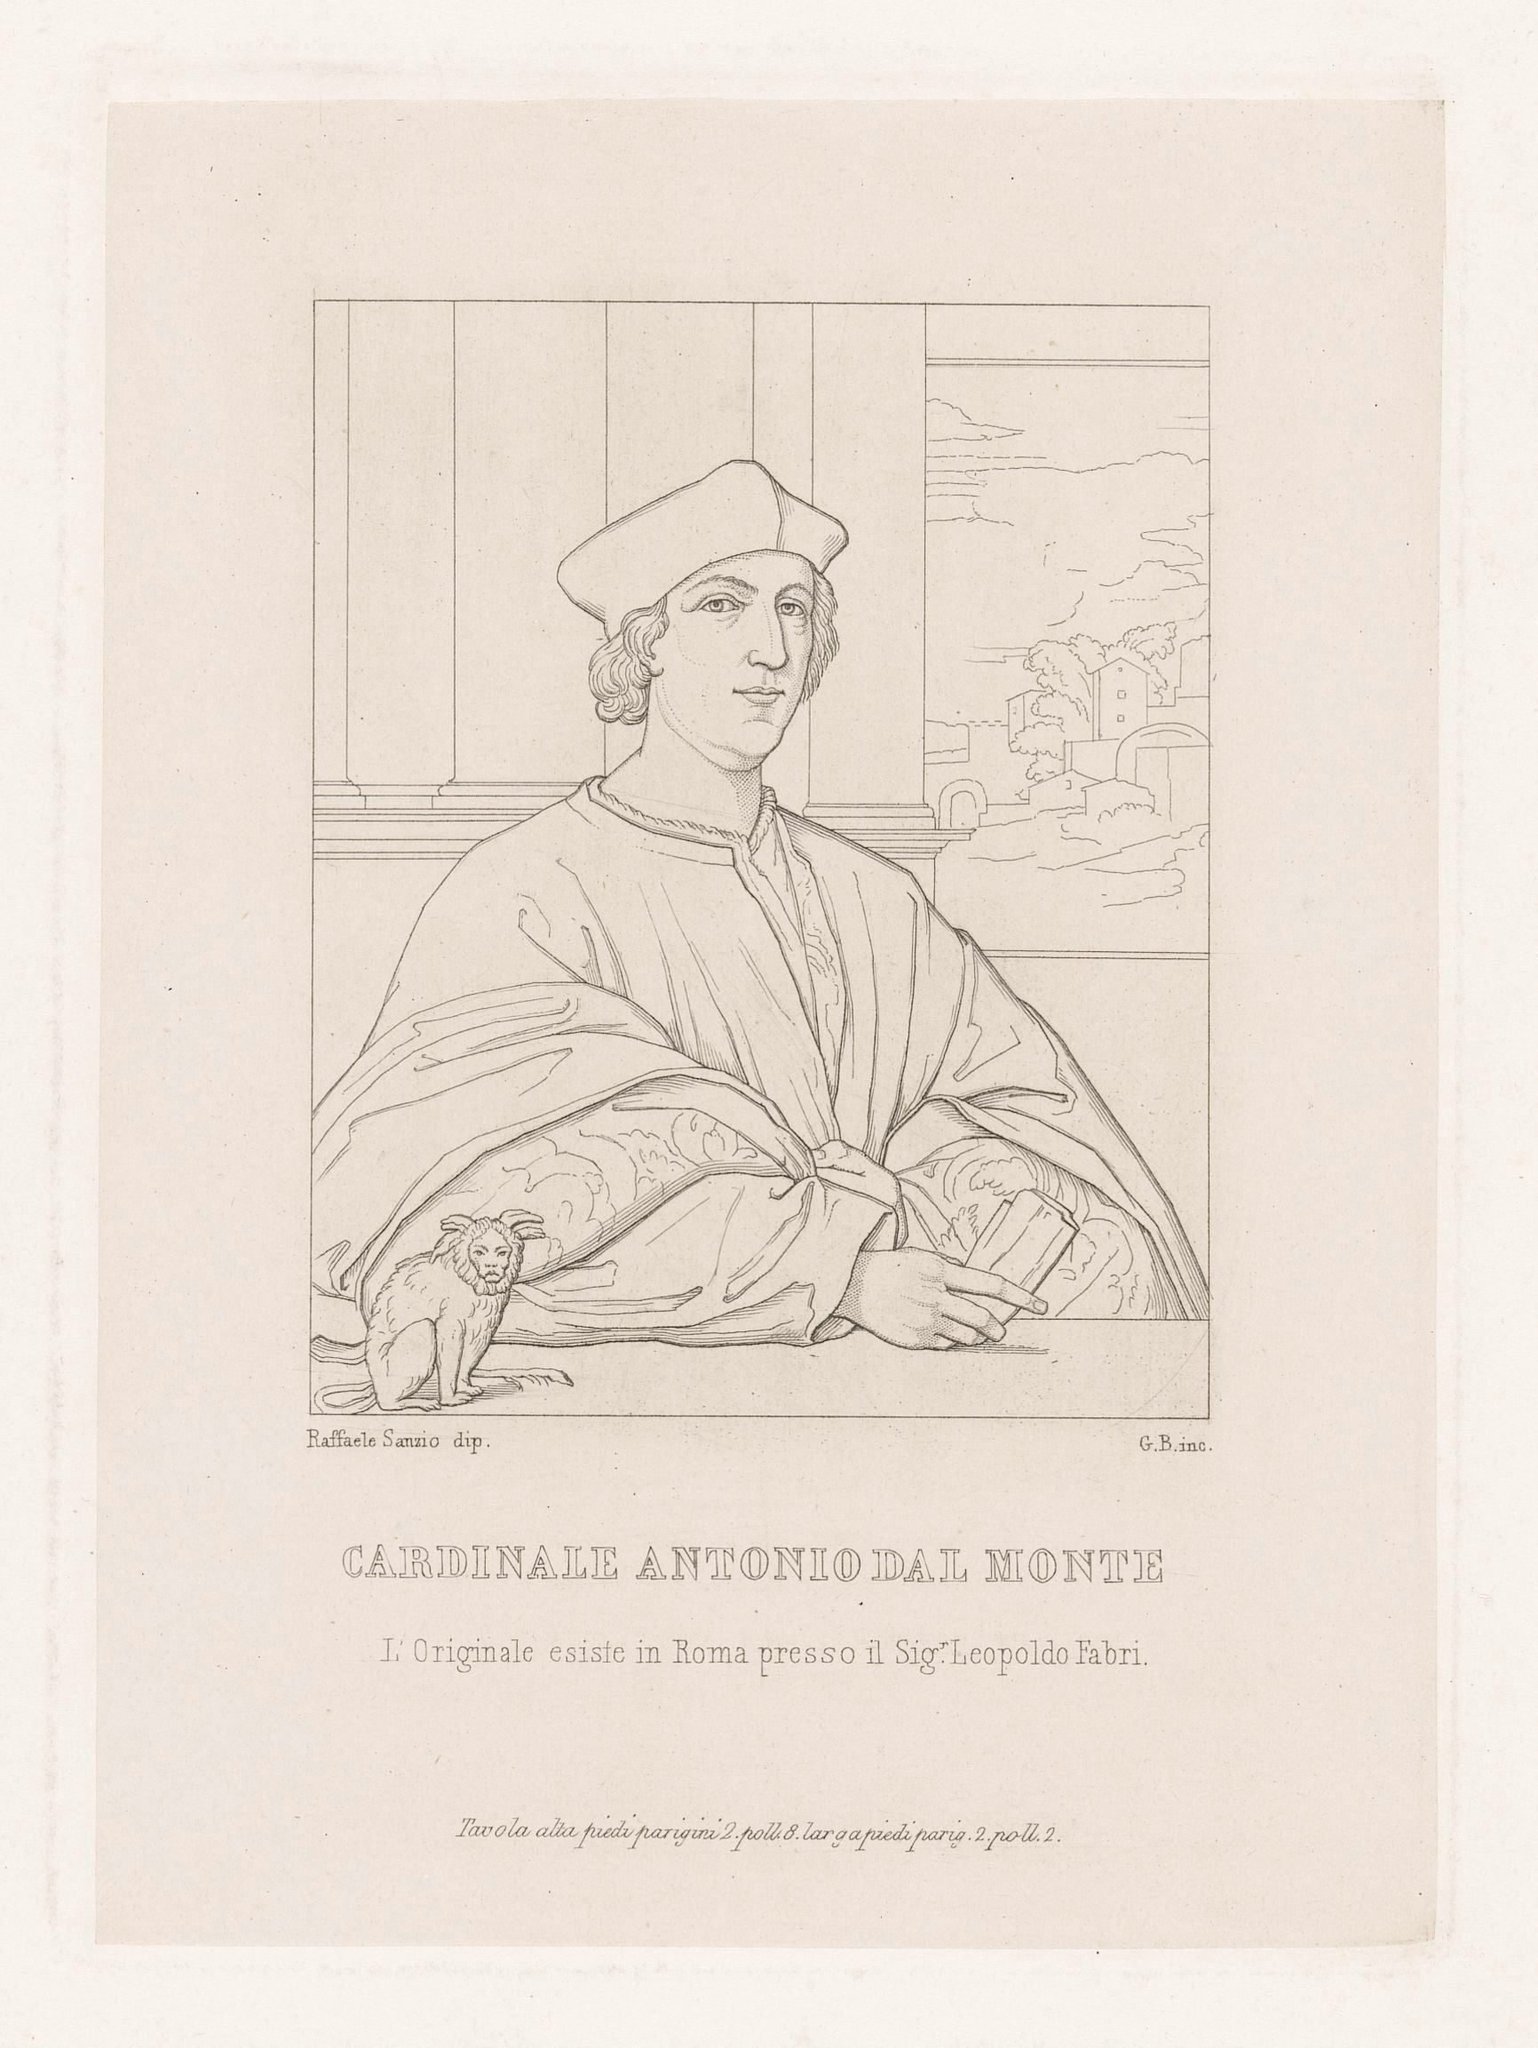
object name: print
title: Portret van kardinaal Antonio Maria Ciocchi del Monte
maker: monogrammist gb (etser)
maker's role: print maker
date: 1800-1899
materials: paper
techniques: etching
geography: italy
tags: italy, cardinal, historical persons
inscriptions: collector's mark: Lugt 2228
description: Naar een schilderij door Sebastiano del Piombo in de National Gallery of Ireland, dat voorheen werd toegeschreven aan Rafaël.